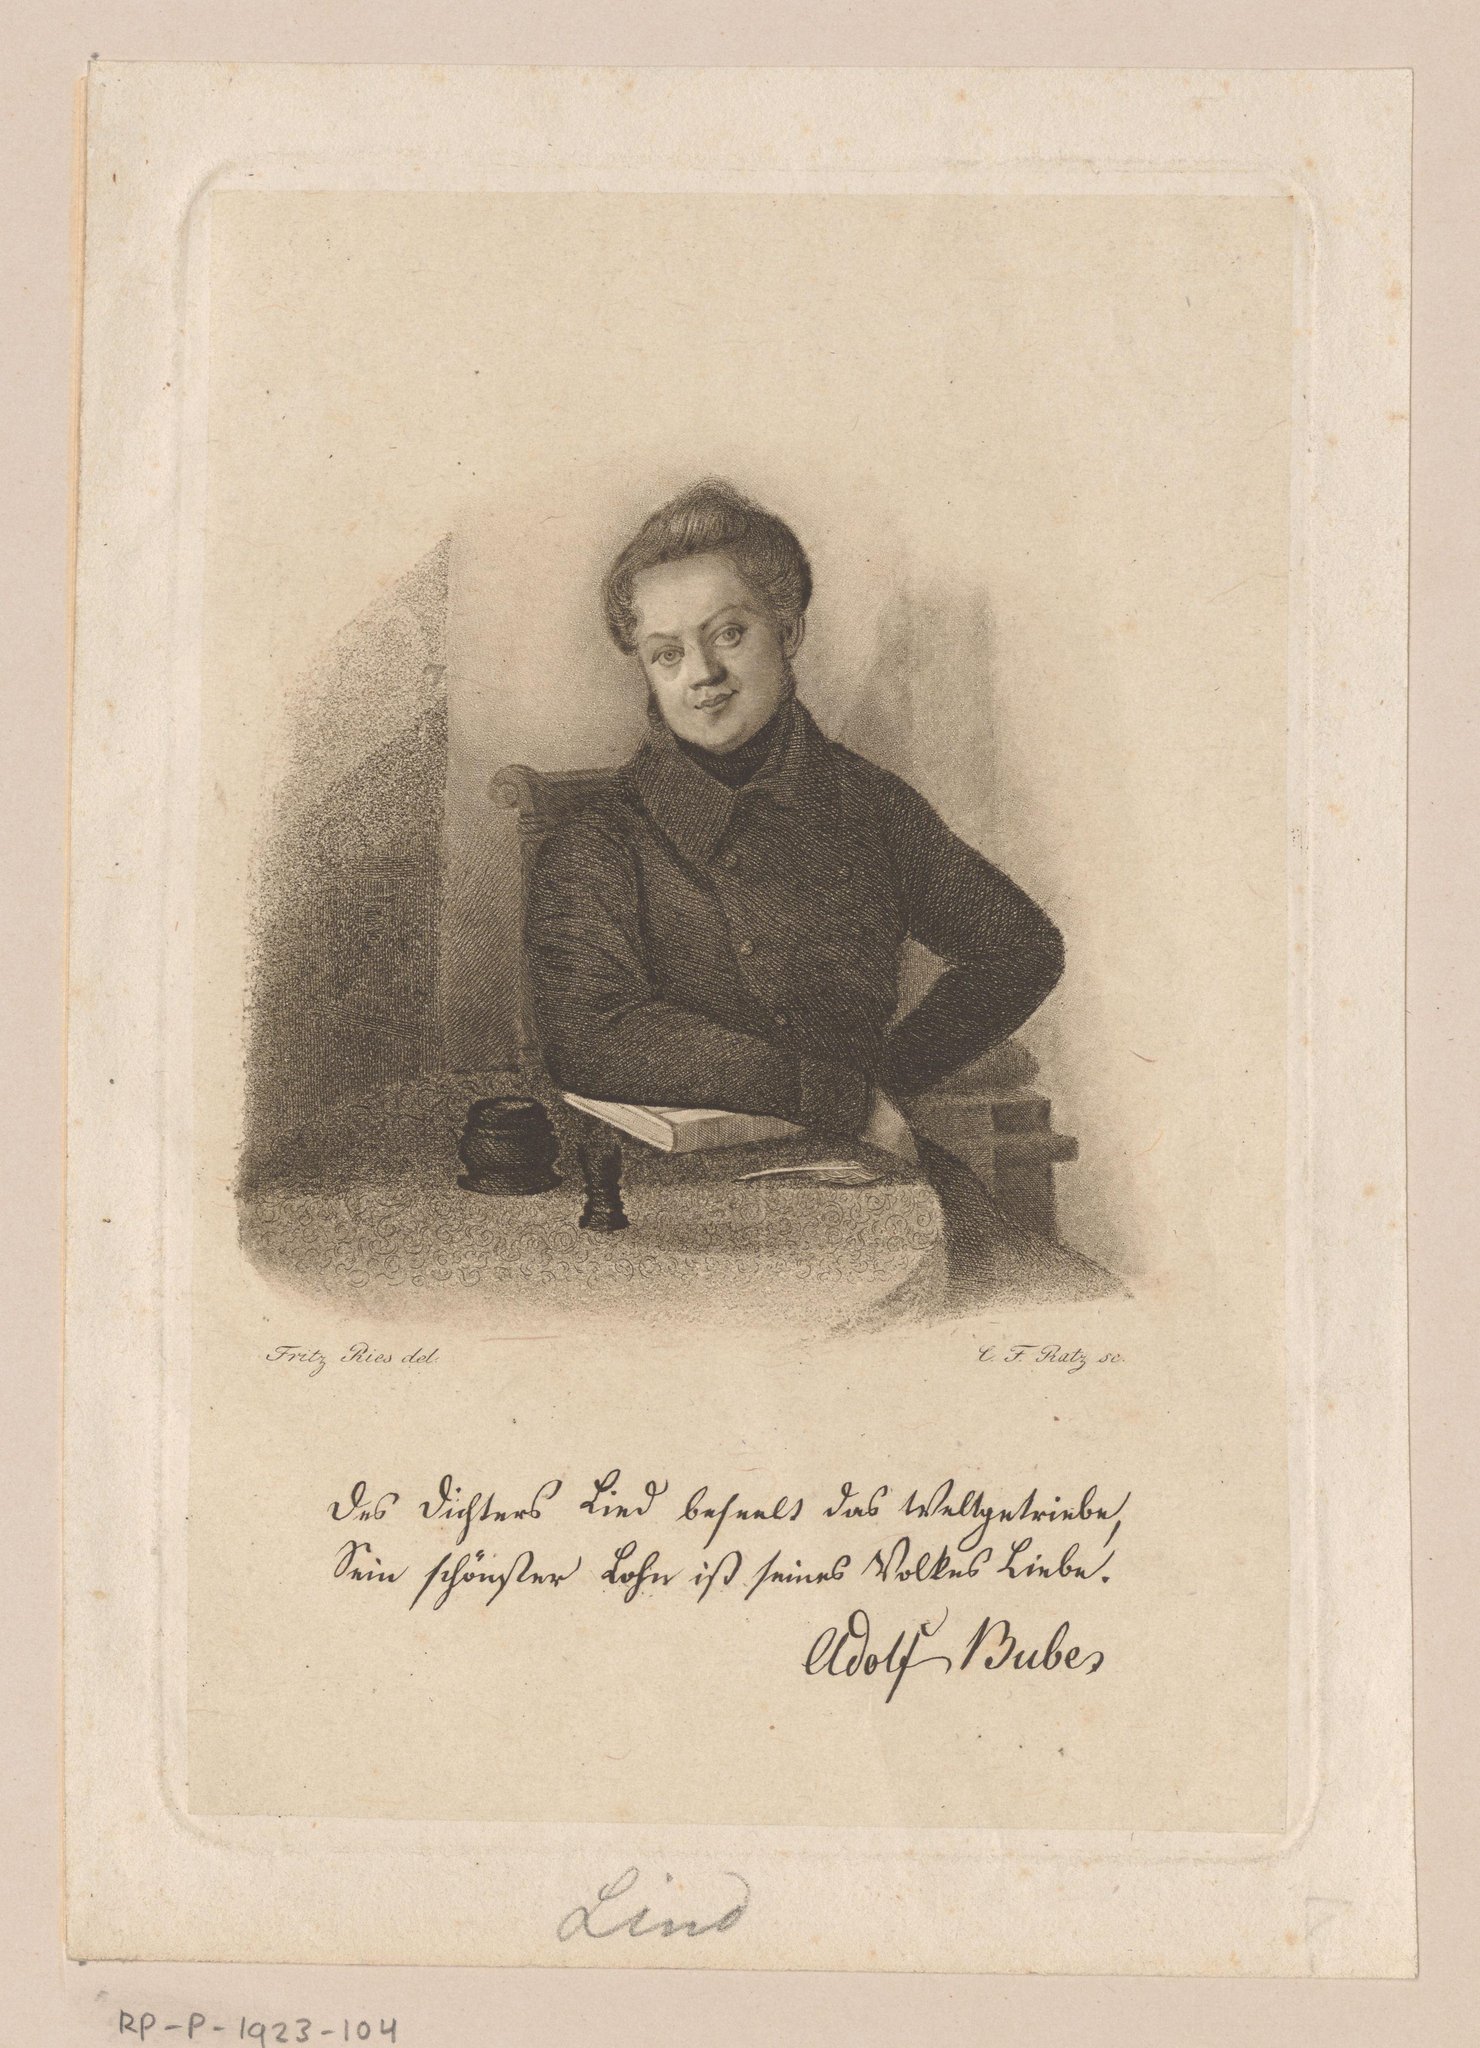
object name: print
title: Portret van mevrouw Lind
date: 1826-1899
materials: paper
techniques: aquatint, etching, roulette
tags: writing tools, anonymous historical person portrayed alone - bb - woman, book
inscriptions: collector's mark: Lugt 2233